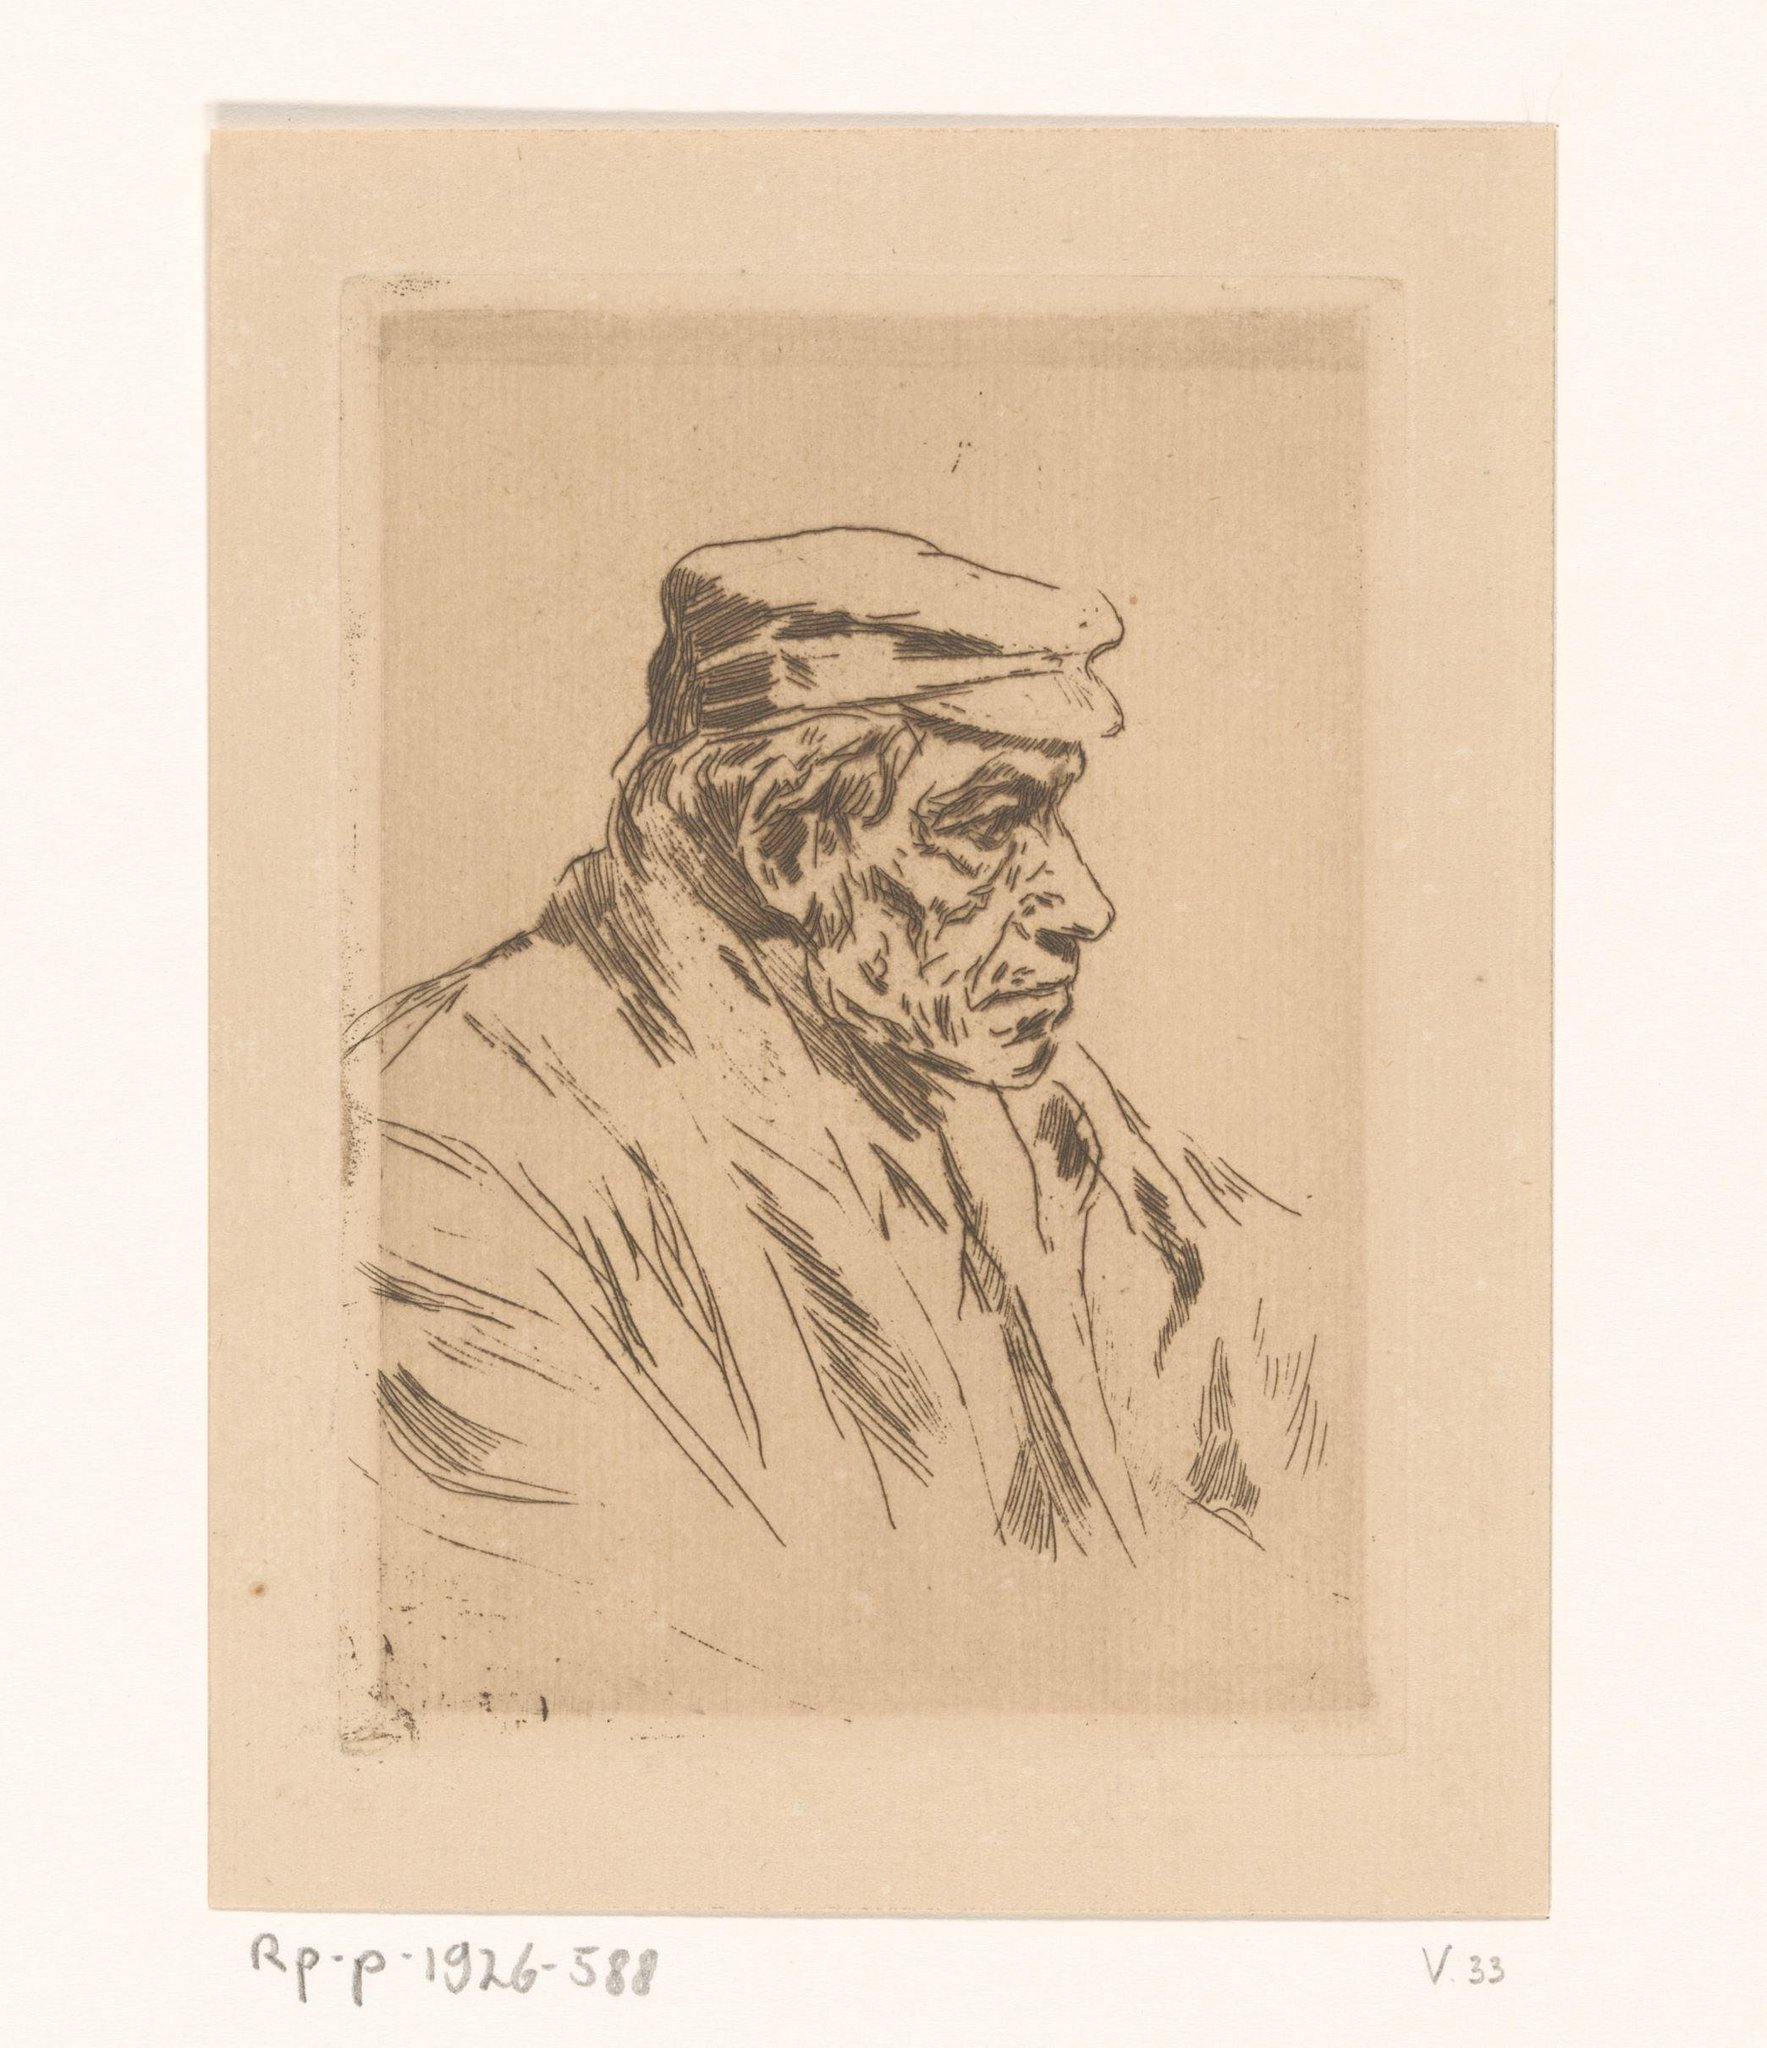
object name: print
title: Oude man met pet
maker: jan veth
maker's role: designer, draughtsman, painter, print maker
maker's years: 1864-1925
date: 1887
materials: paper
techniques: etching, intaglio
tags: old man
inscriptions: collector's mark: Lugt 2228